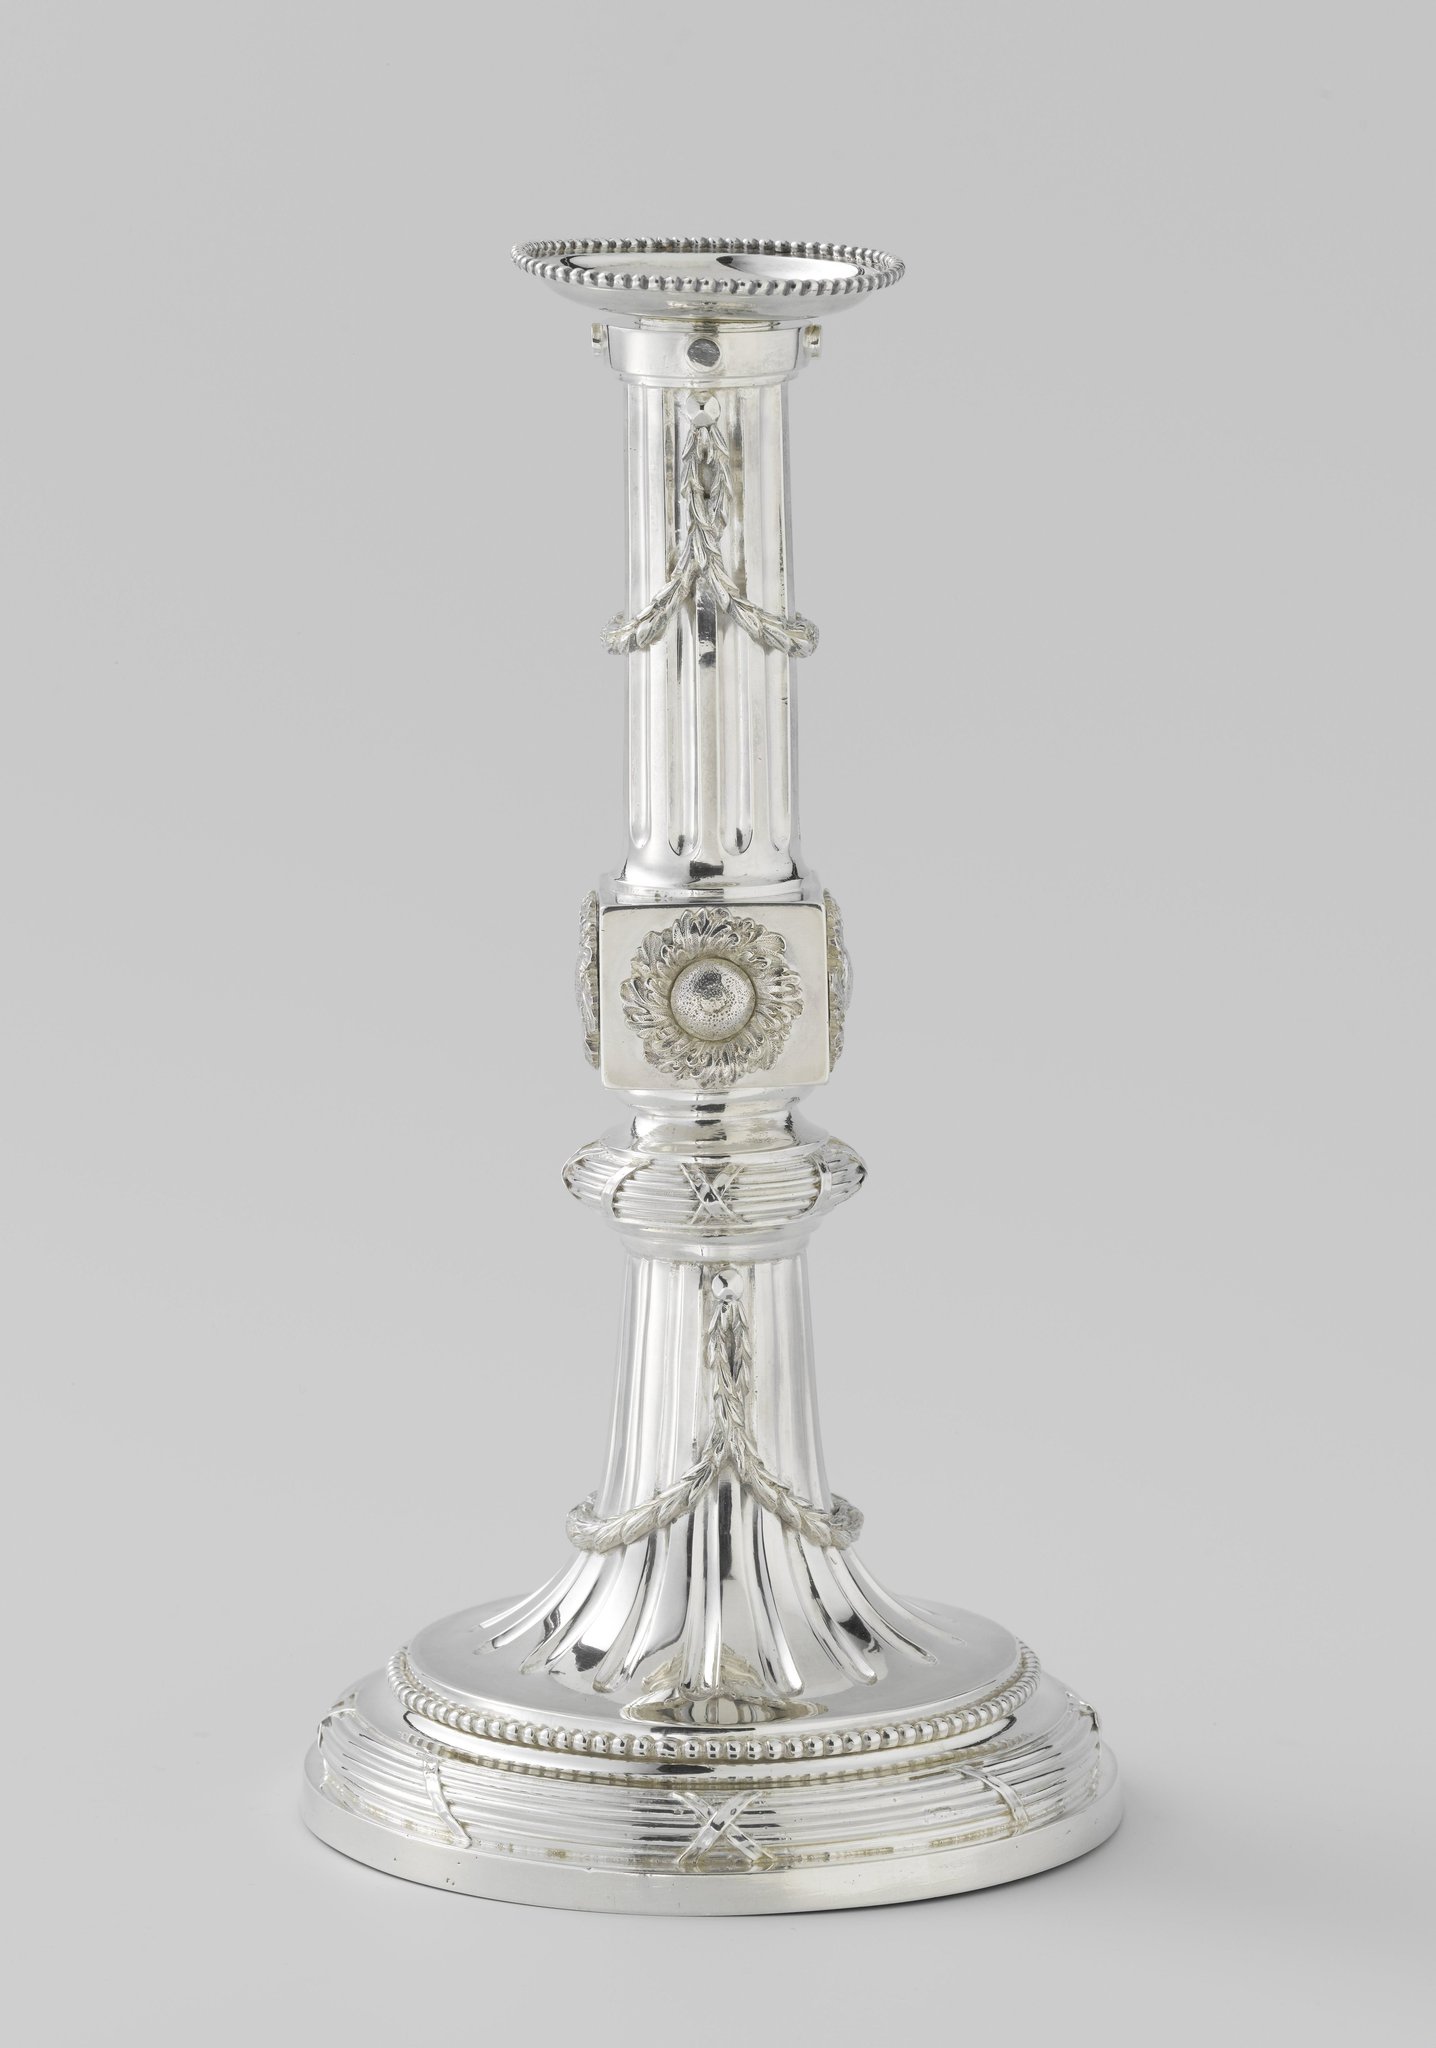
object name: candlestick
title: Four candlesticks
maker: cornelis hendrik bömcke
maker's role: silversmith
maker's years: 1758-1818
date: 1783-1784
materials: silver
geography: amsterdam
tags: ornaments ~ art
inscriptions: alloy mark, date letter: ‘Y’, maker's mark, town mark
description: The design of these candlesticks, with a cubic knob with rosettes in the middle of the stem, is derived from Parisian models. Similar candlesticks were made in various European centres, but the quality of these Amsterdam examples comes very close to that of the silver produced in Paris.